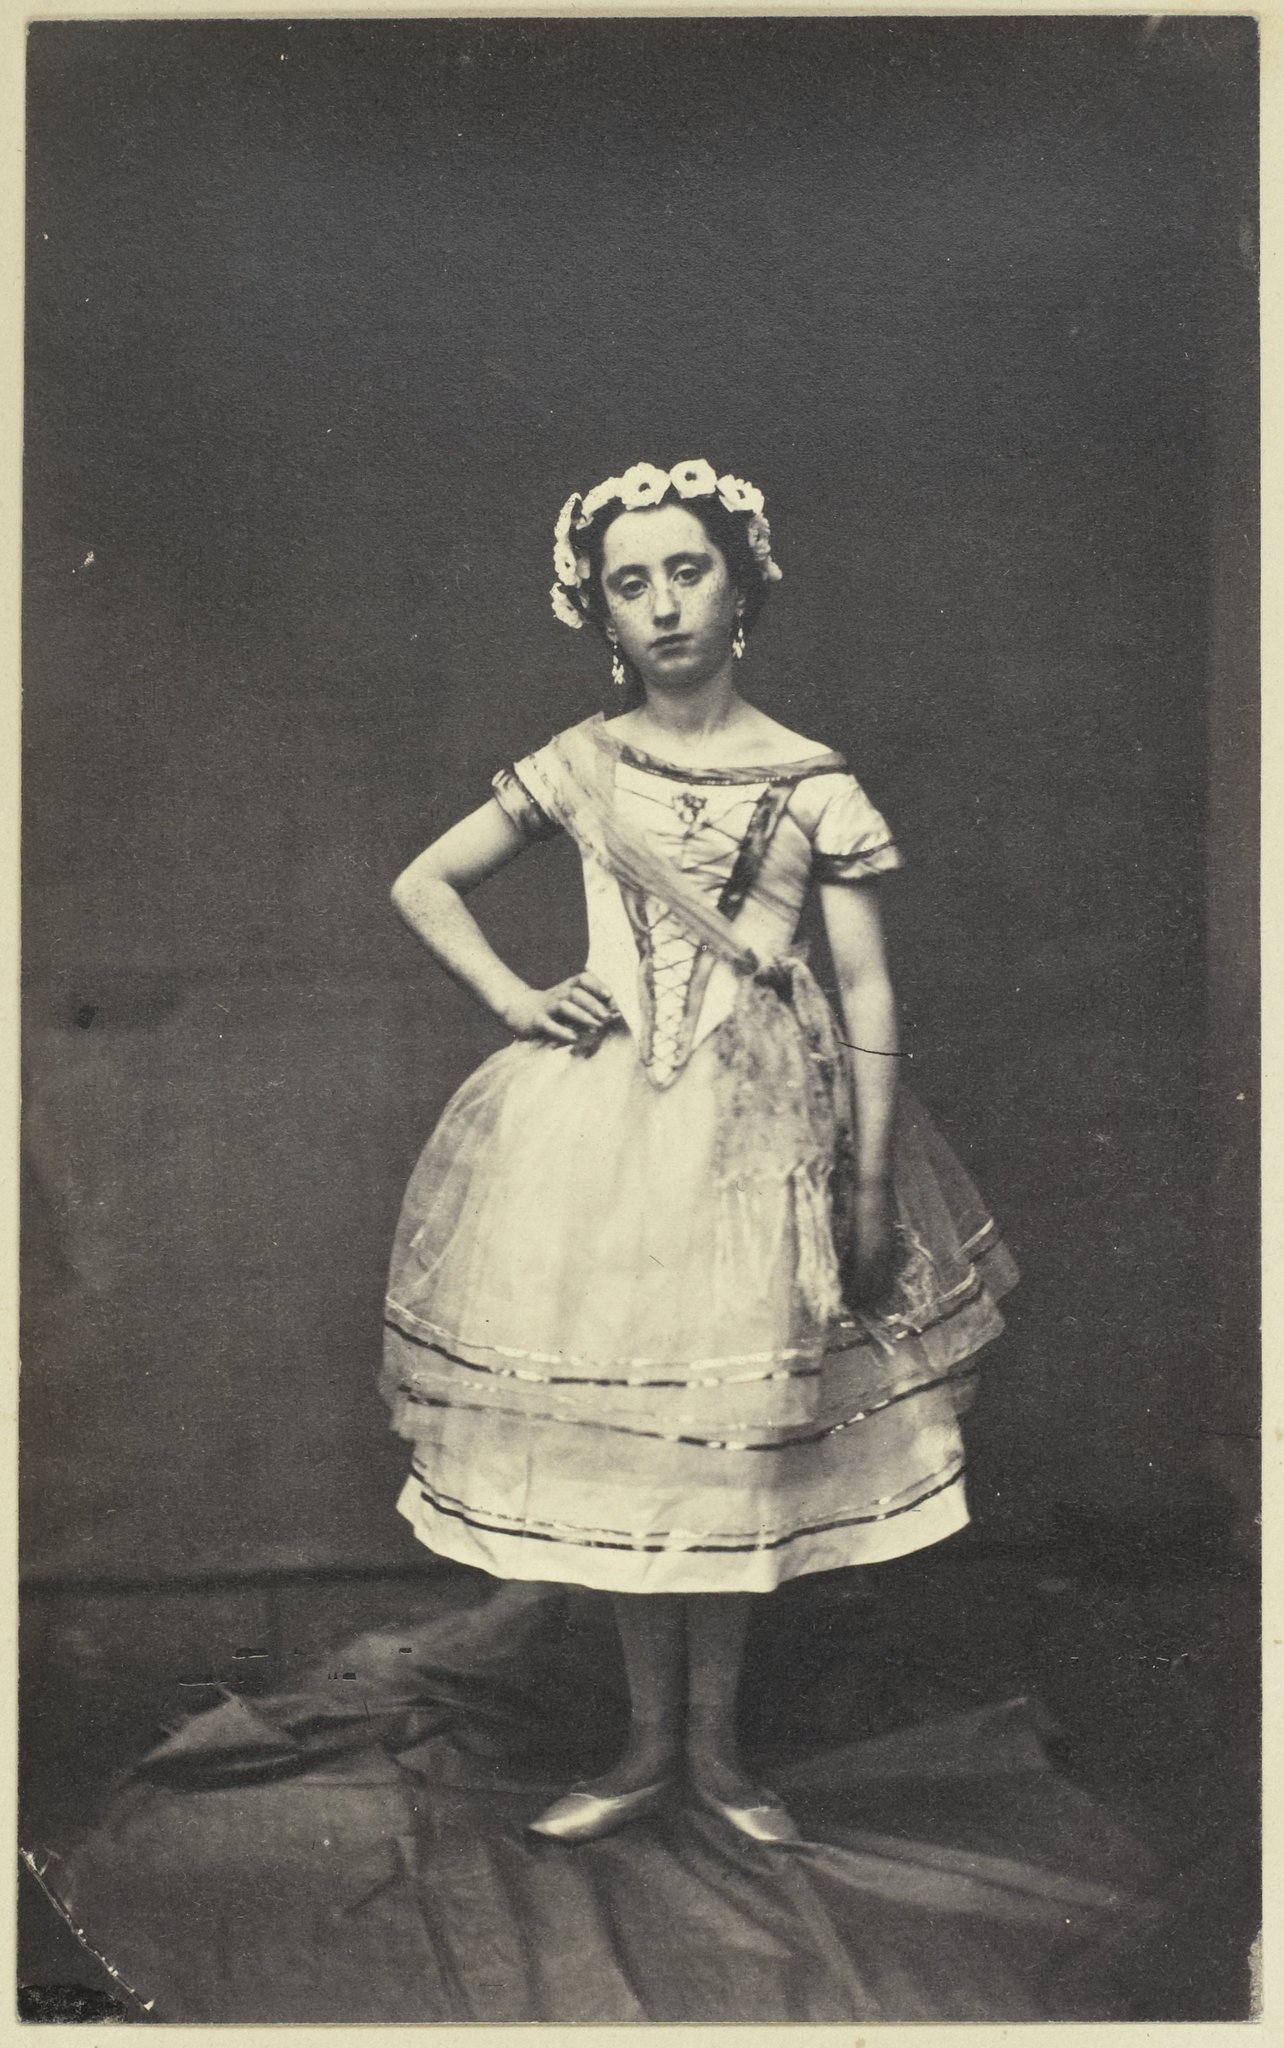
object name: photograph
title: Portret van een meisje in tule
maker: eduard isaac asser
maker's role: amateurfotograaf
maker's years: 1809-1894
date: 1856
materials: cardboard, paper, photographic support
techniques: salted paper print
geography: amsterdam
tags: historical persons - bb - woman